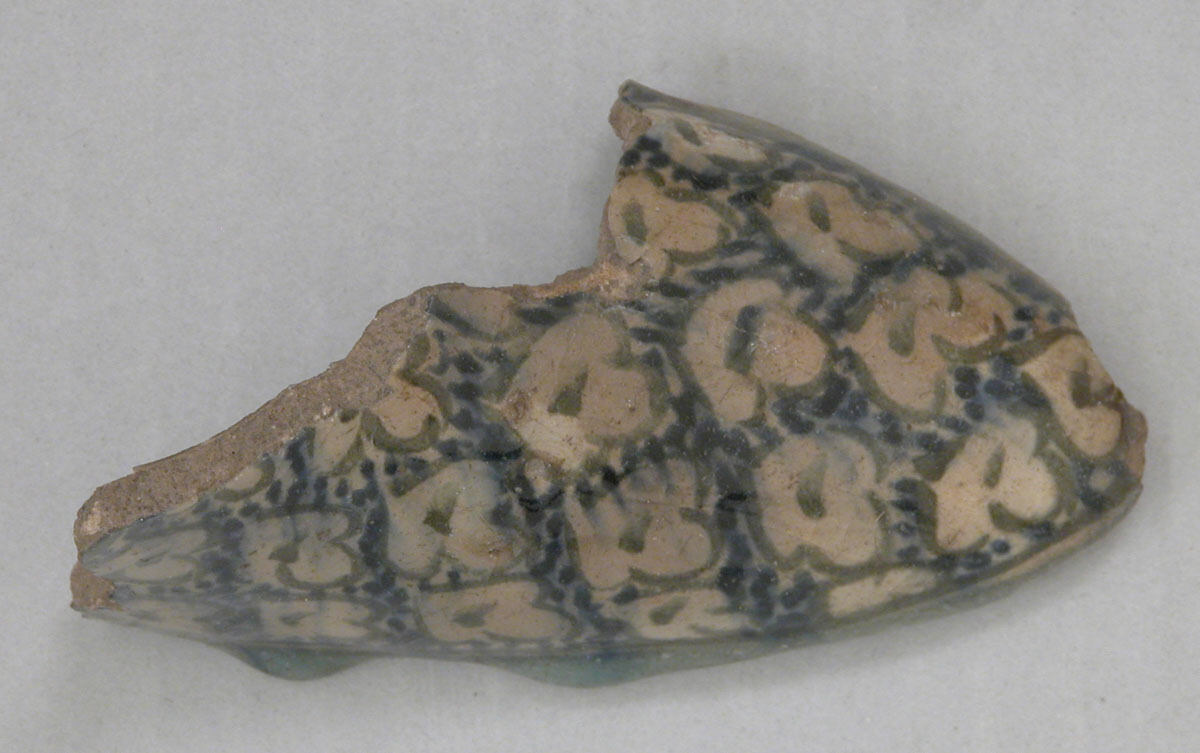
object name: fragment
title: Ceramic Fragment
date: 1301-1500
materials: glaze, stonepaste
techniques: painting, polychrome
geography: egypt